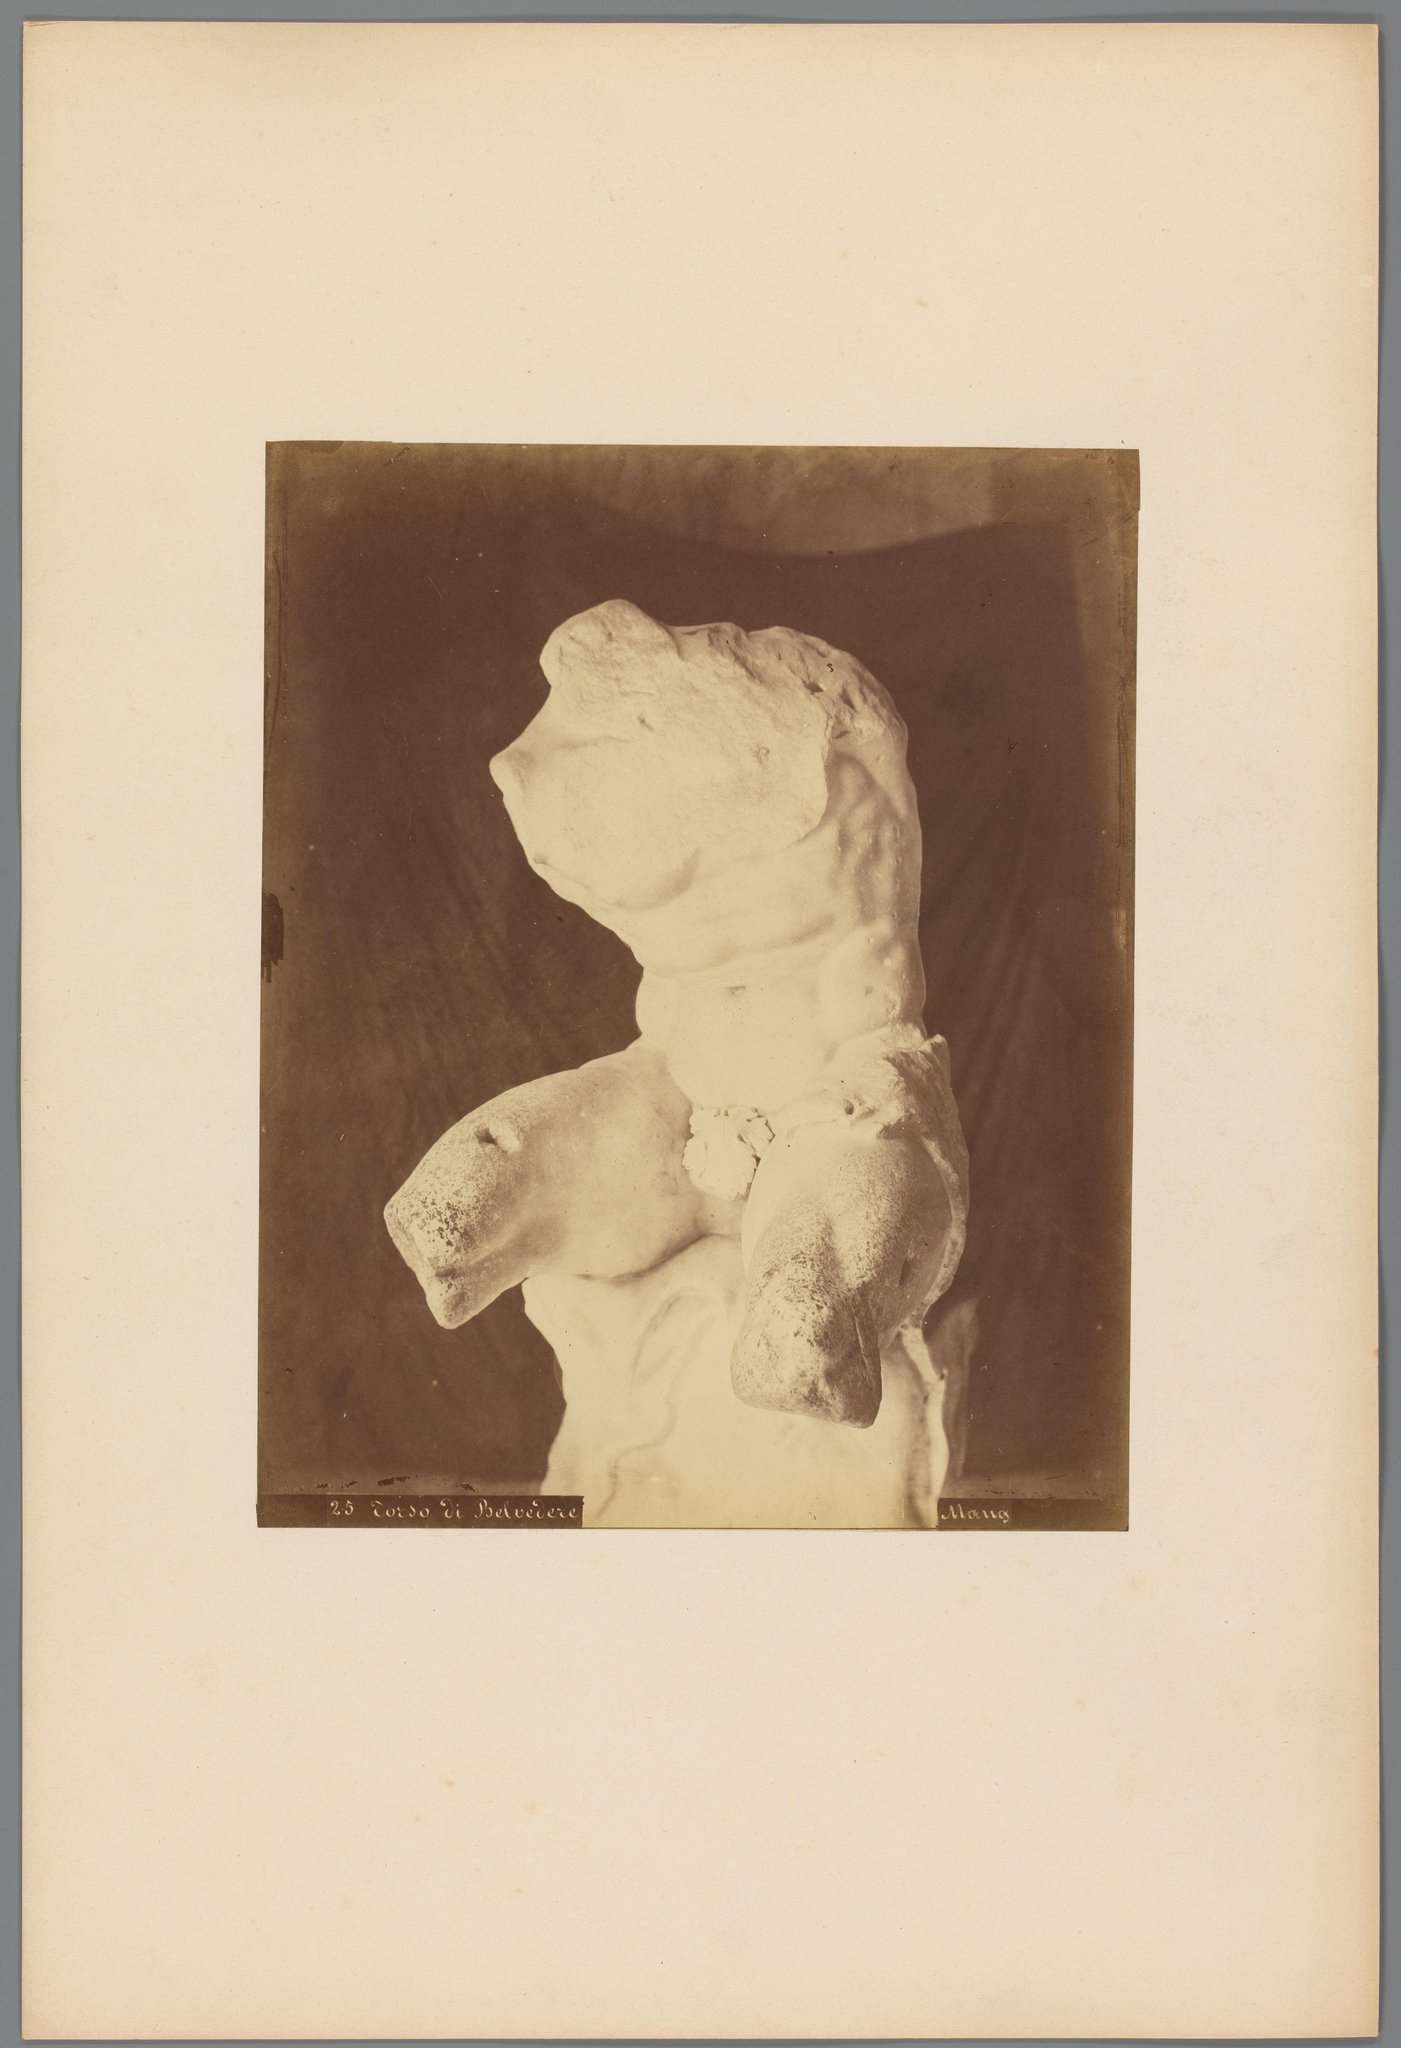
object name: photograph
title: Torso di Belvedere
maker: michèle mang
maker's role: fotograaf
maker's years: 1840-1909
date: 1863-1887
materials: cardboard, paper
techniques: albumen print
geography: vatican city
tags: torso, piece of sculpture, reproduction of a piece of sculpture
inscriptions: number: ‘25’